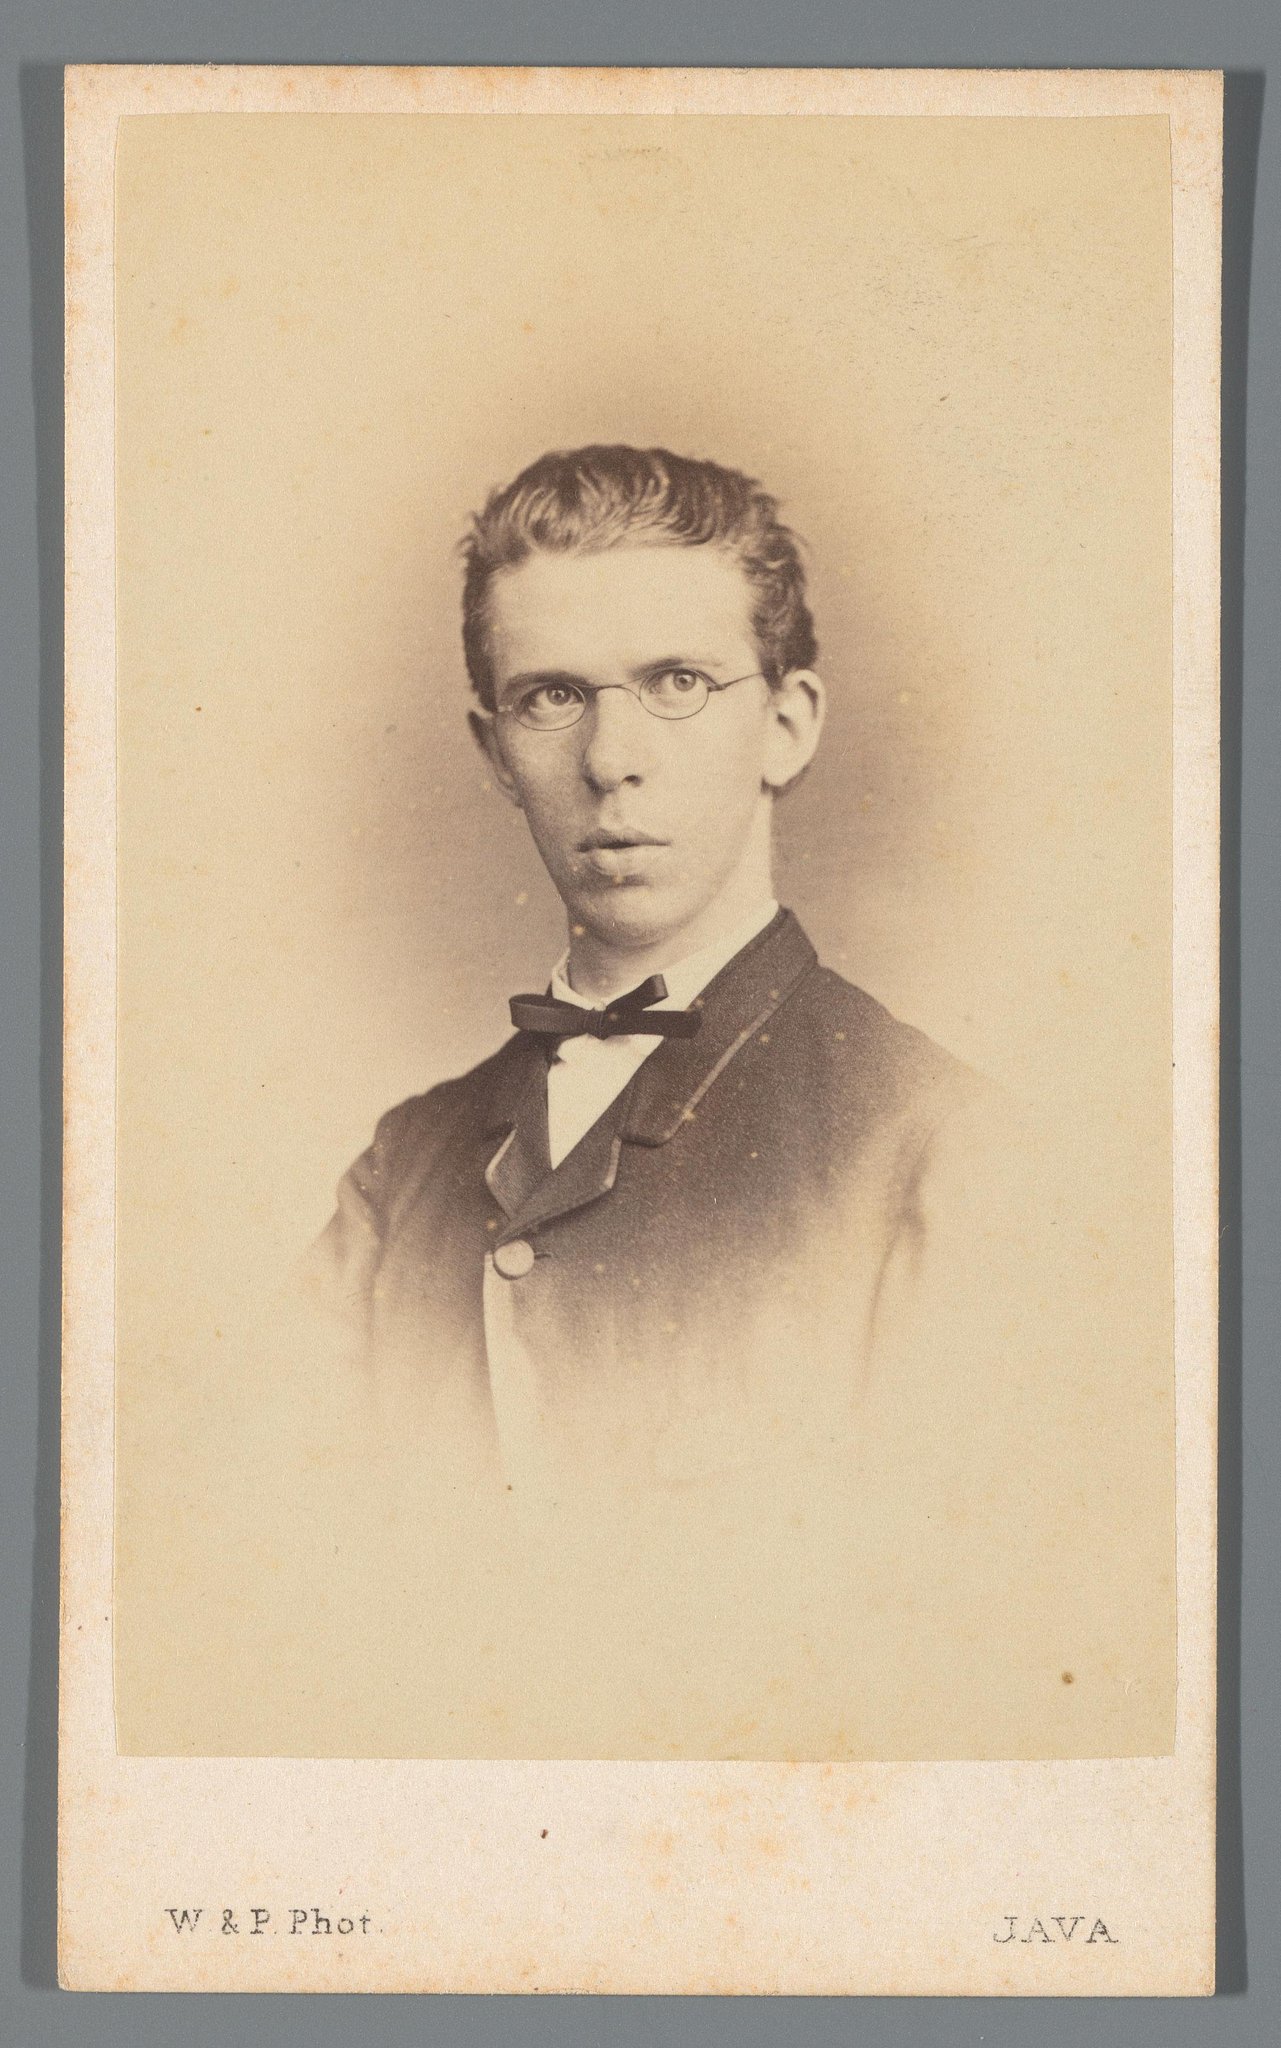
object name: photograph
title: Portret van Henricus Petrus Joannes van den Berg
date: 1860-1880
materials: cardboard, photographic support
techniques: albumen print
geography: java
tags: nice, henricus petrus joannes van den berg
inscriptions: name: ‘WOODBURY & PAGE , / PHOTOGRAPHERS / JAVA .’, name: ‘W.&P. Phot. JAVA’